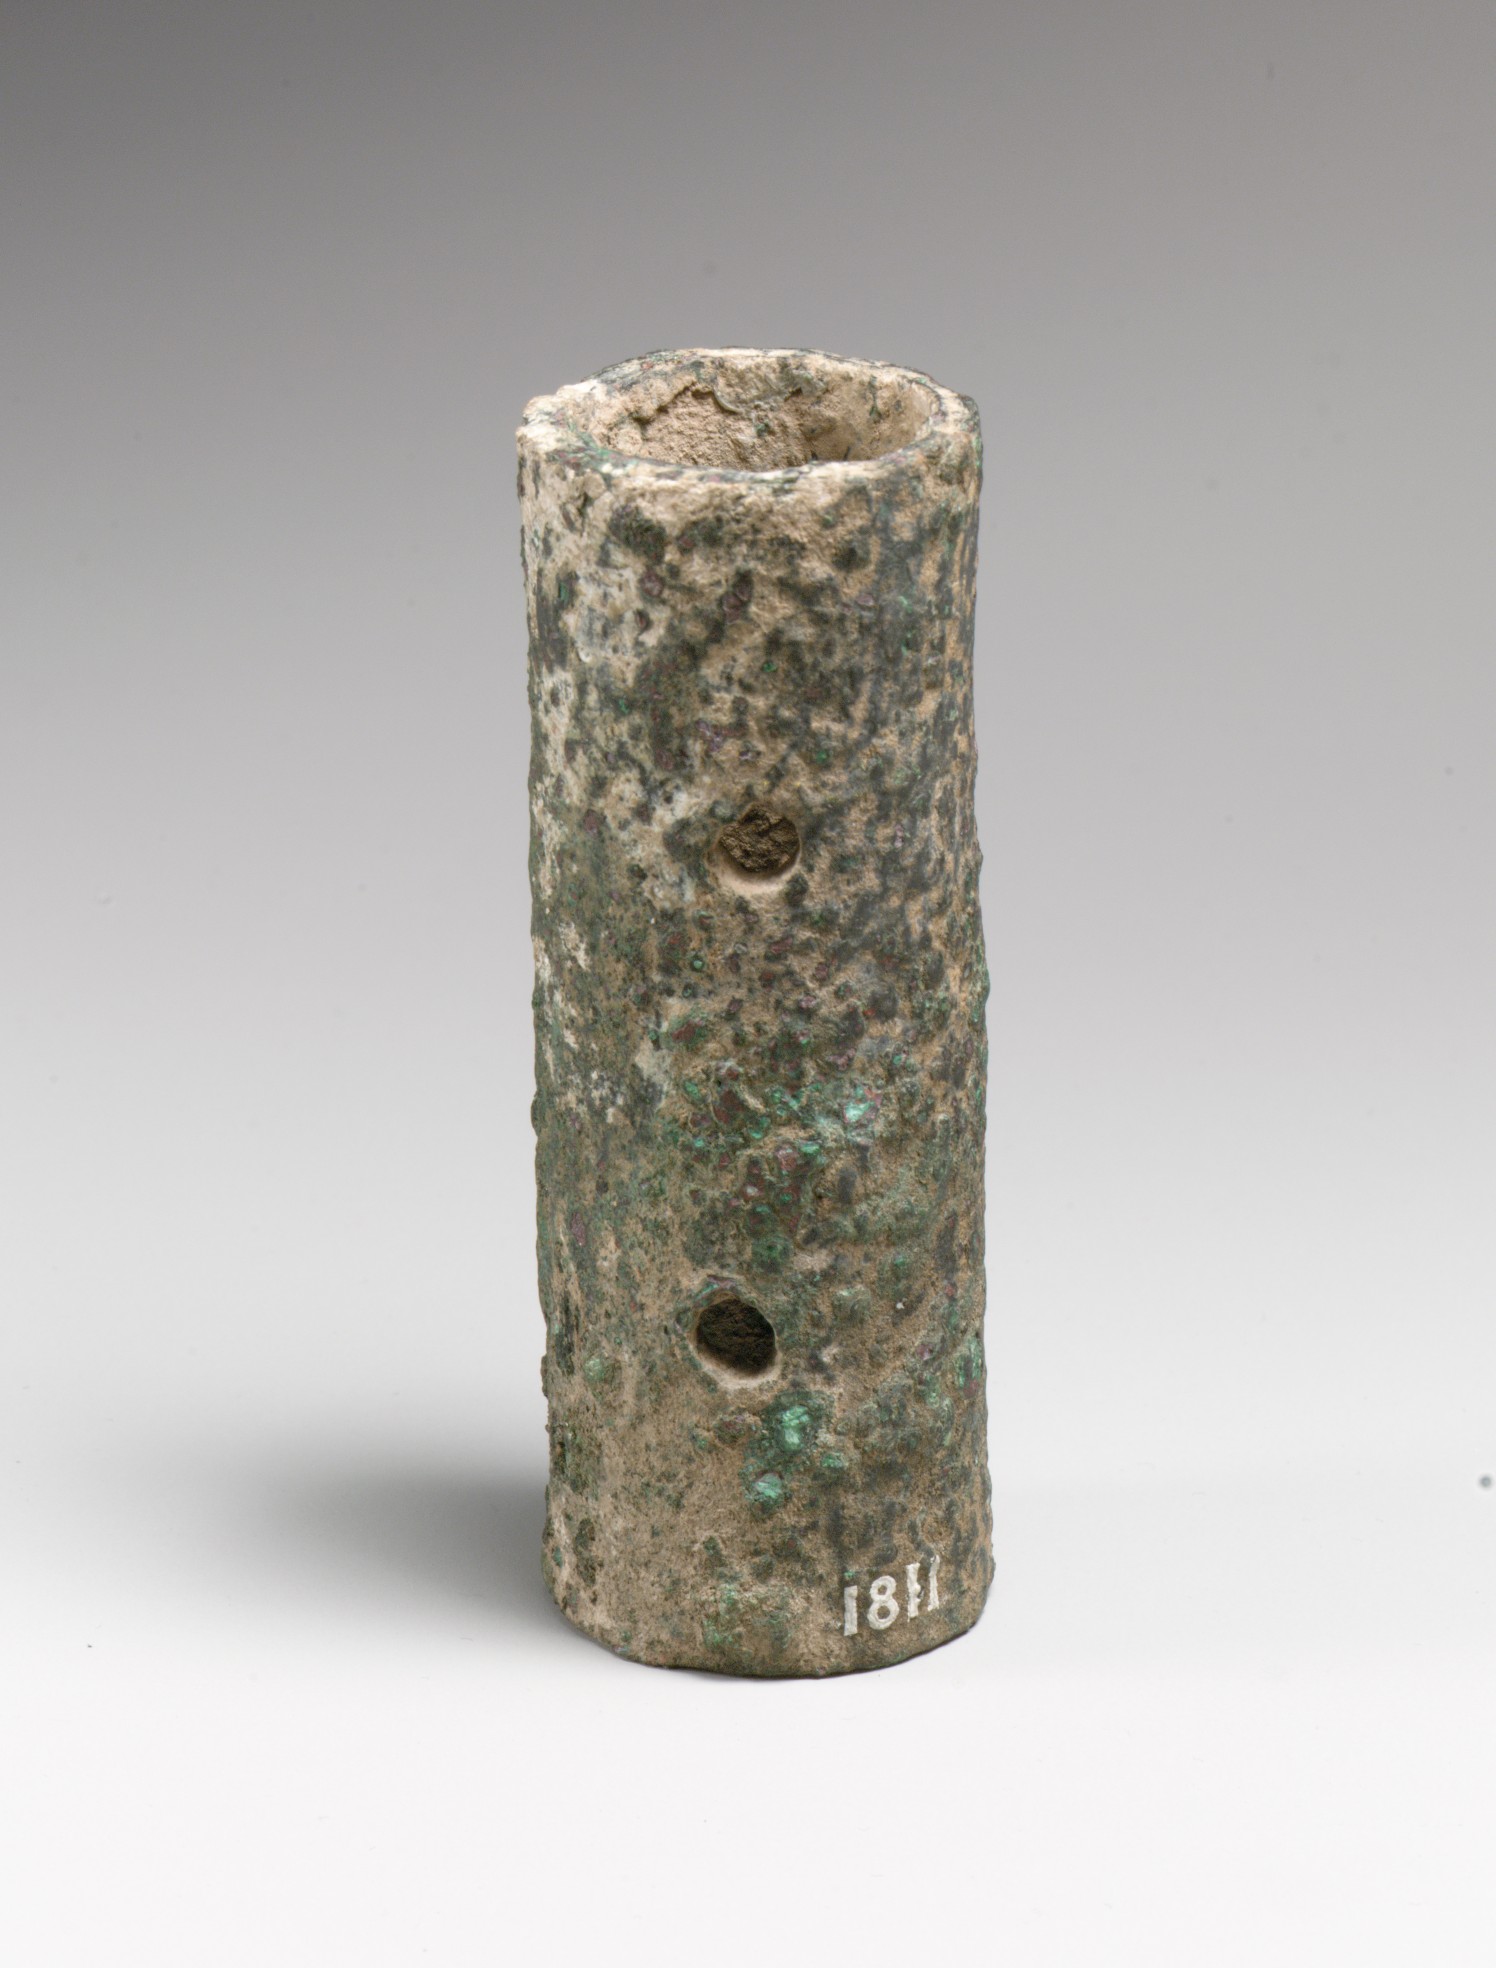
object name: cylinder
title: Bronze cylindrical fitting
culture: minoan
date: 1600-1050 BCE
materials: bronze